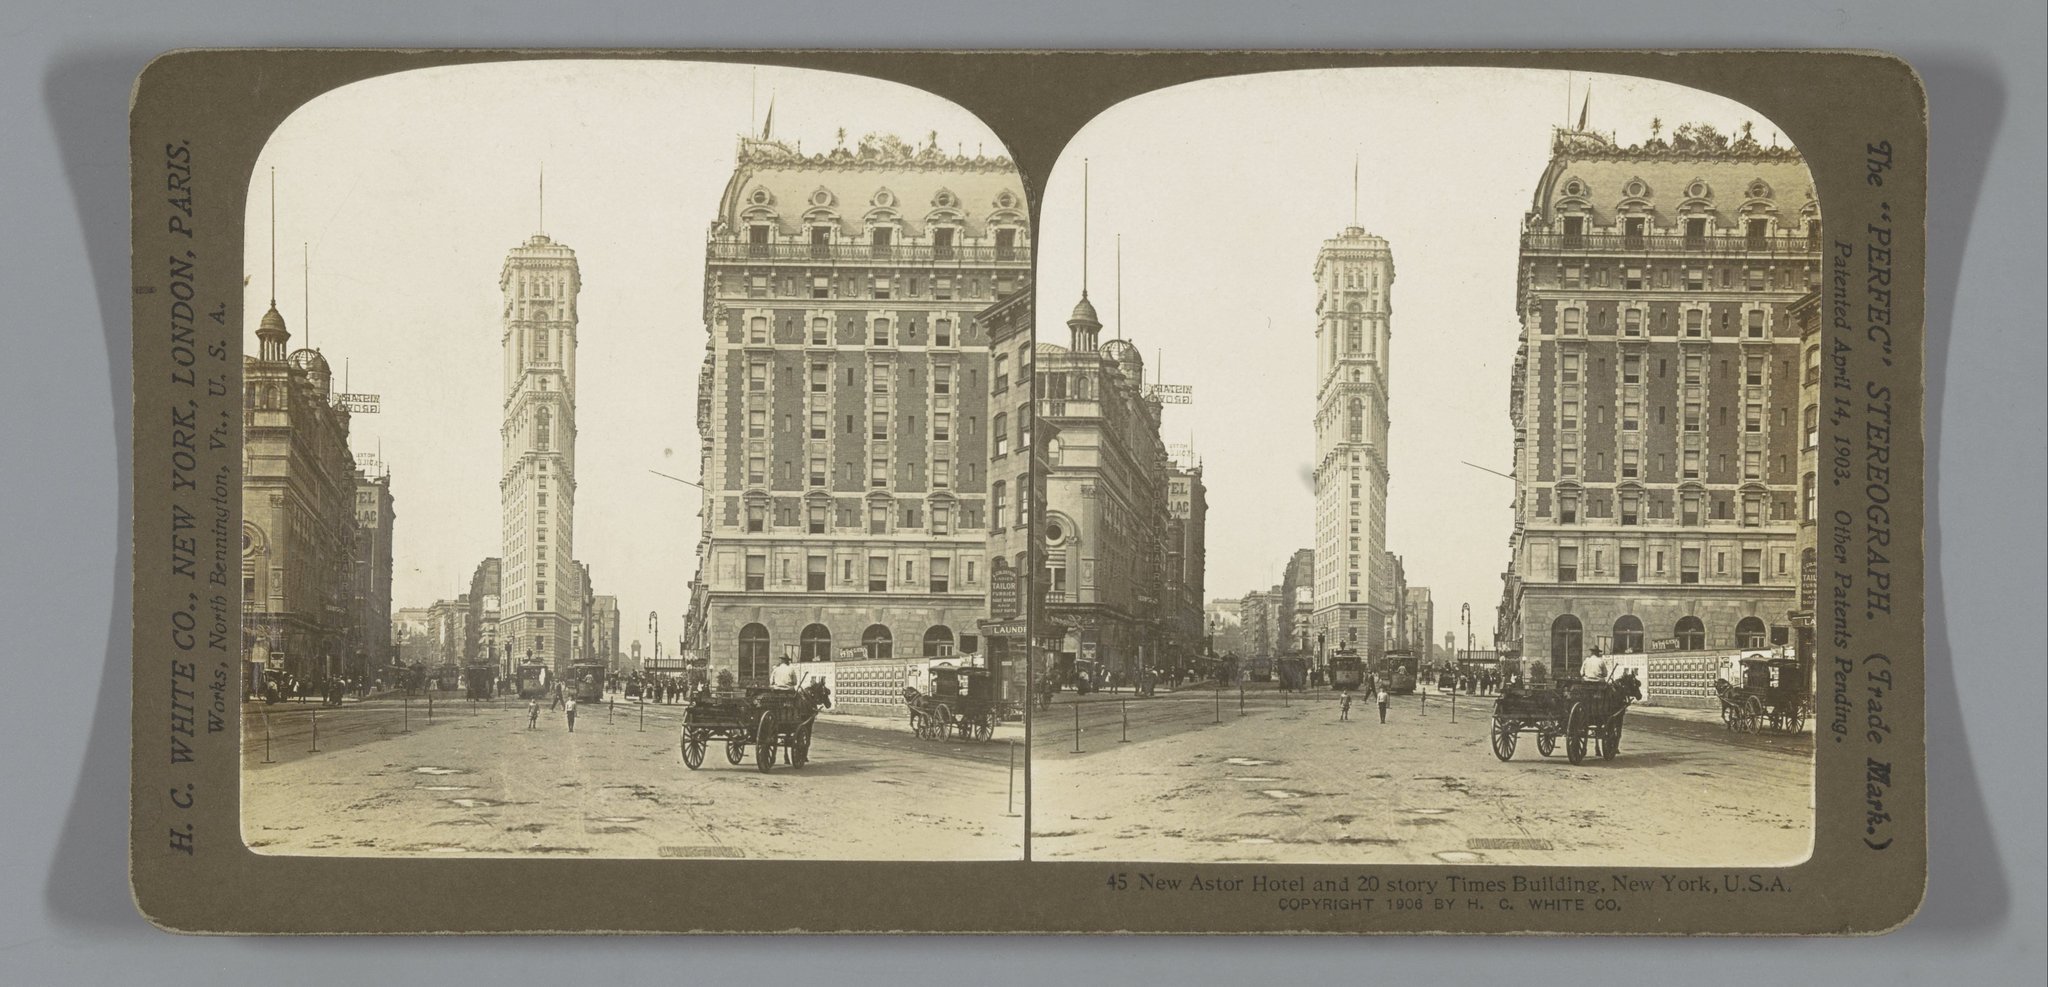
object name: stereograph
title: New Astor Hotel and 20 story Times Building, New York, U.S.A.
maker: Anonymous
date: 1906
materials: paper, cardboard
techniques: gelatin silver print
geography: new york city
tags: city-view in general; 'veduta'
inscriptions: copyright notice: ‘Copyright 1906 by H. C. White Co.’, number: ‘45’, inscription: ‘The " PERFEC" STEREOGRAPH. (Trade Mark.)/ Patented April 14, 1903. Other Patents Pending.’